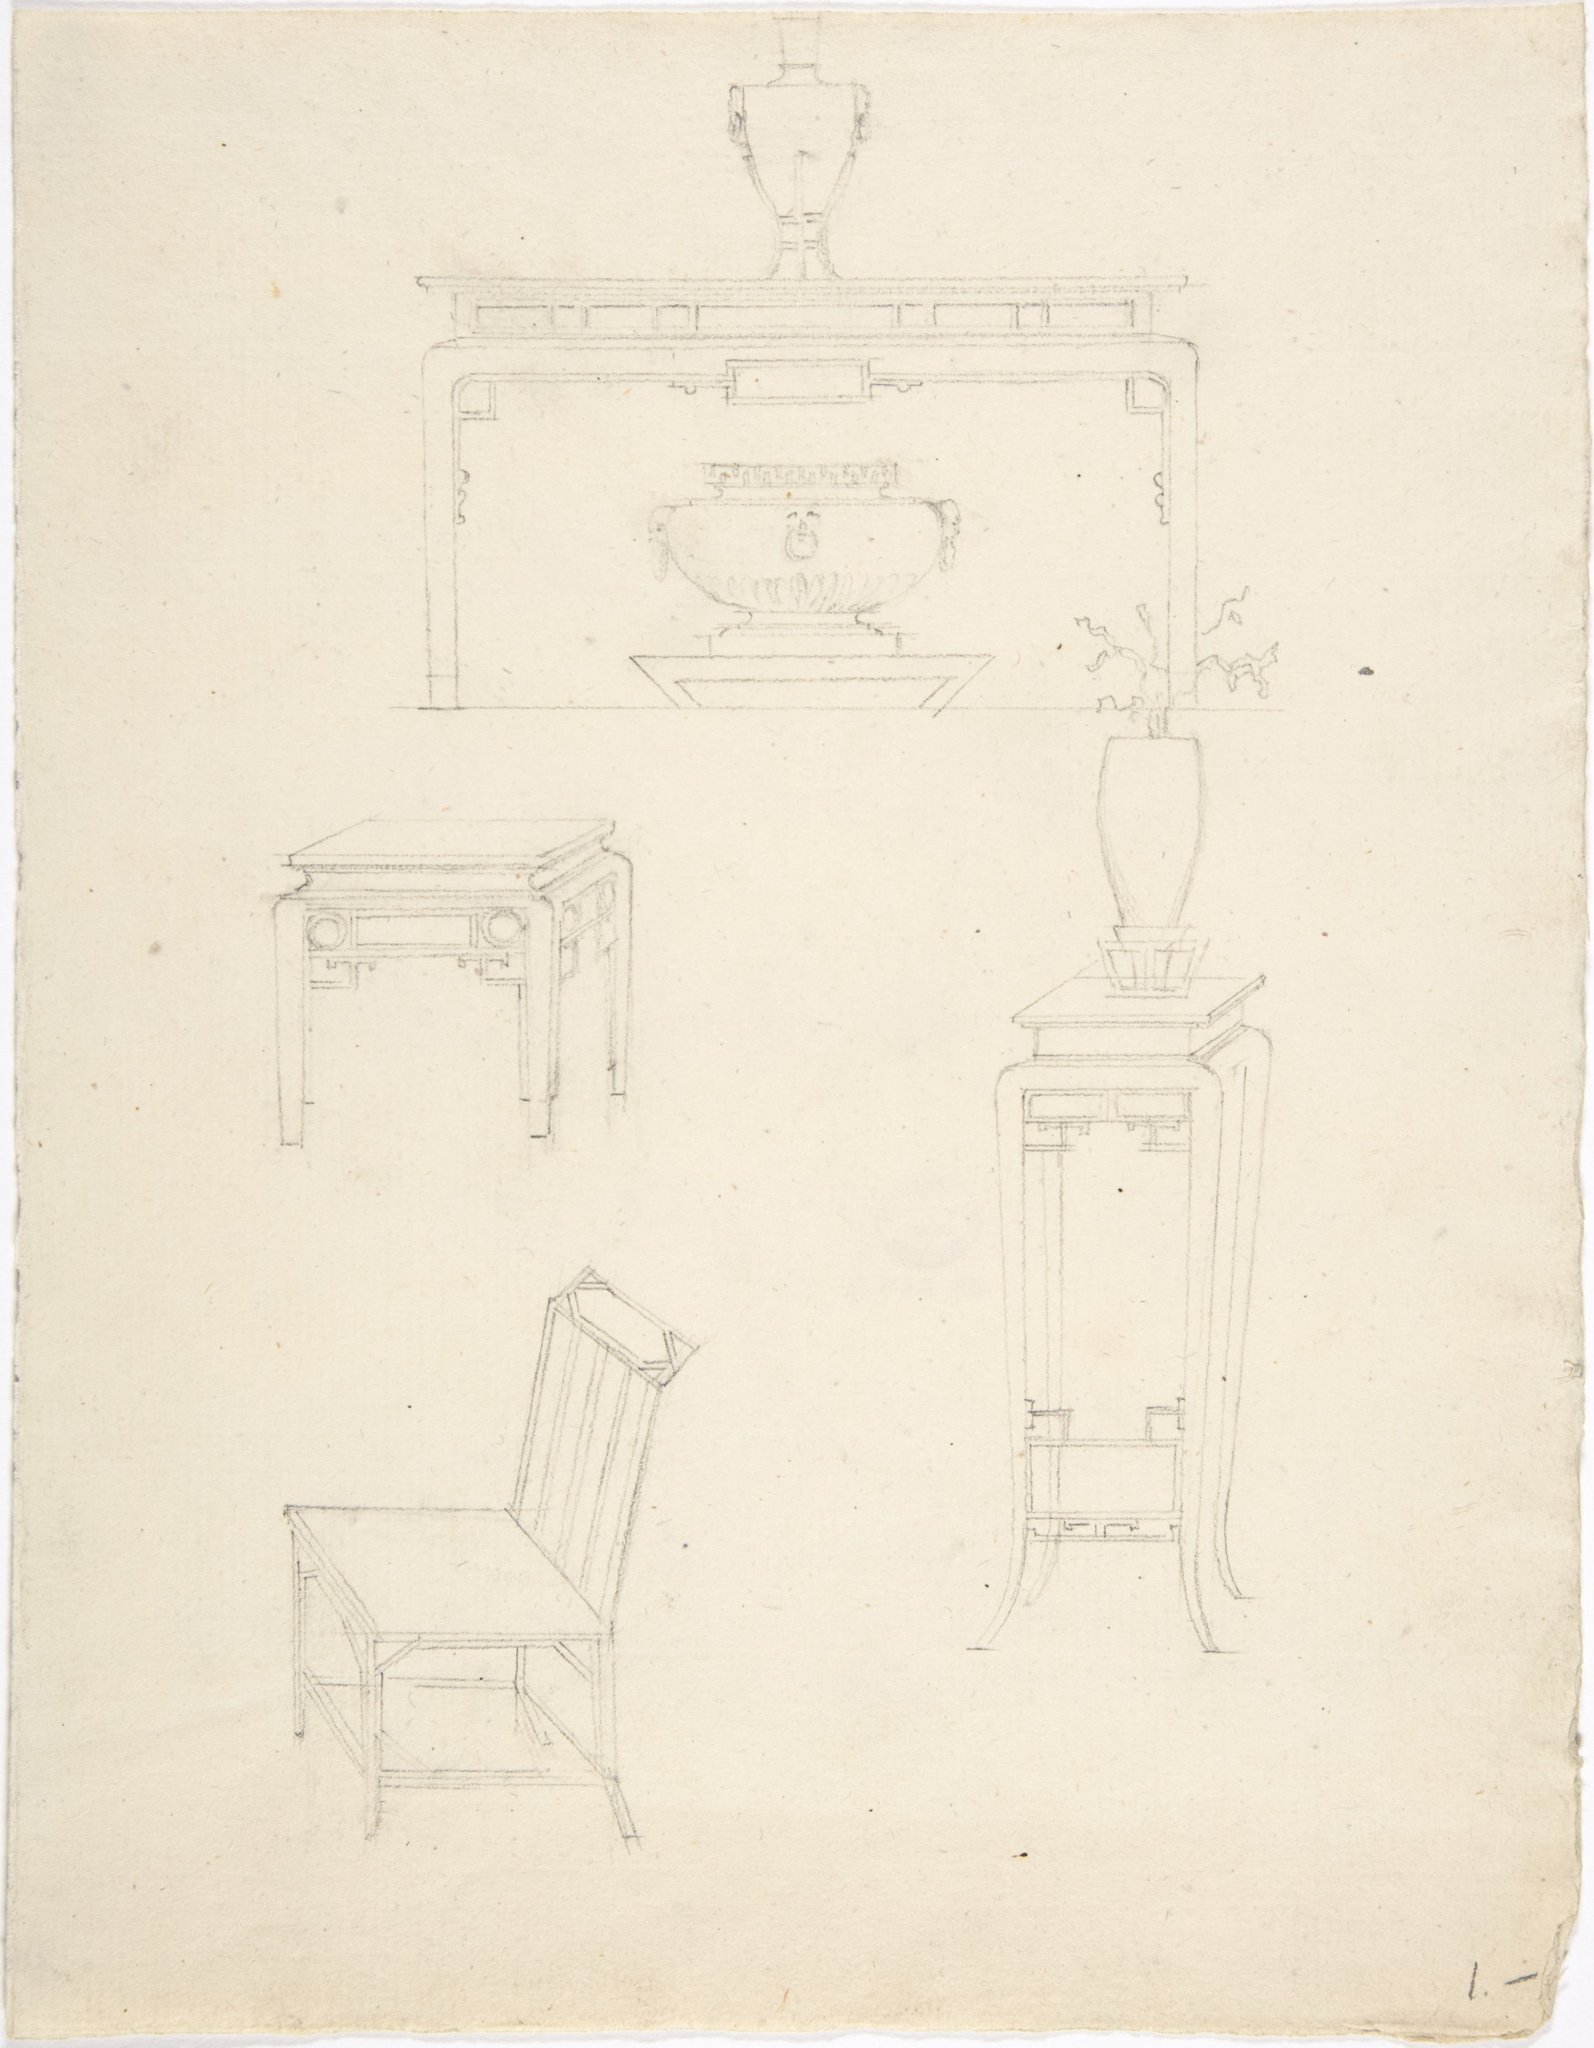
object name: drawing ornament architecture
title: Designs for Chinoiserie Furniture: Three Tables and a Chair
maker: anonymous, italian, 18th or early 19th century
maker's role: artist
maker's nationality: italian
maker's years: 1700-1850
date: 1800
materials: drawing material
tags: chinoiserie,chairs,tables,vases